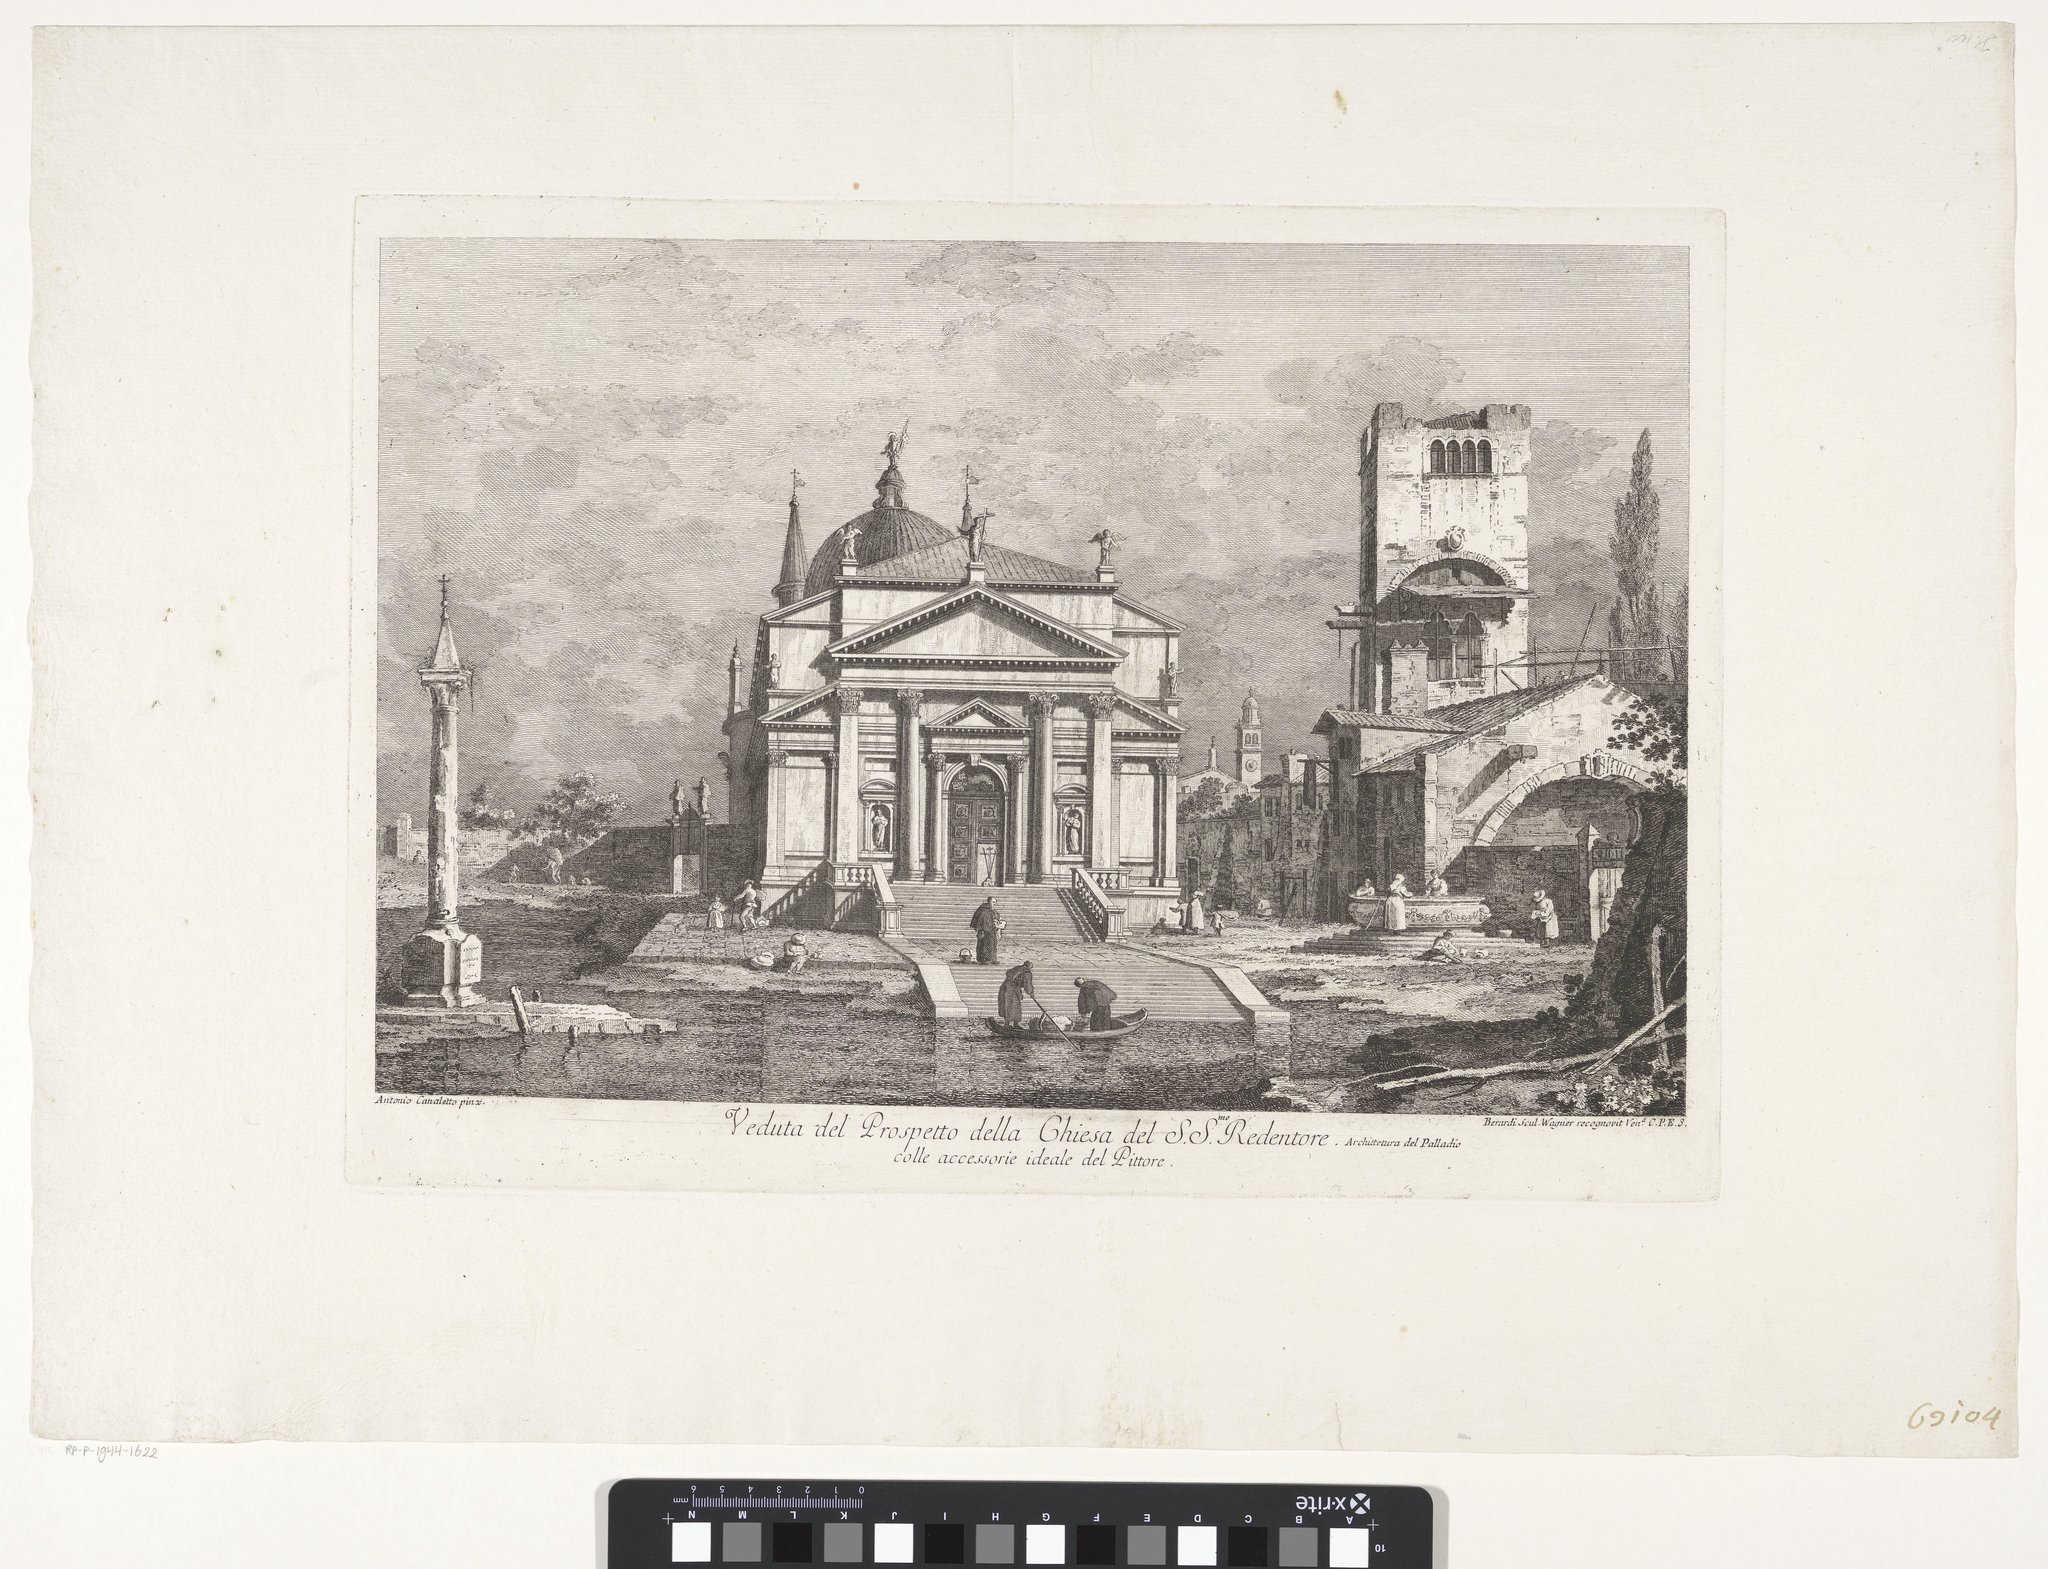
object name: print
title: Veduta del Prospetto della Chiesa del S.S.mo Redentore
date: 1738-1800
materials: paper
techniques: etching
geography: italy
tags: andrea palladio, church (exterior), venice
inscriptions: collector's mark: Lugt 2228, number: ‘69104’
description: Gezicht op Il Redentore (Chiesa del Santissimo Redentore) op het eiland Giudecca te Venetië. De kerk is ontworpen door Andrea Palladio.